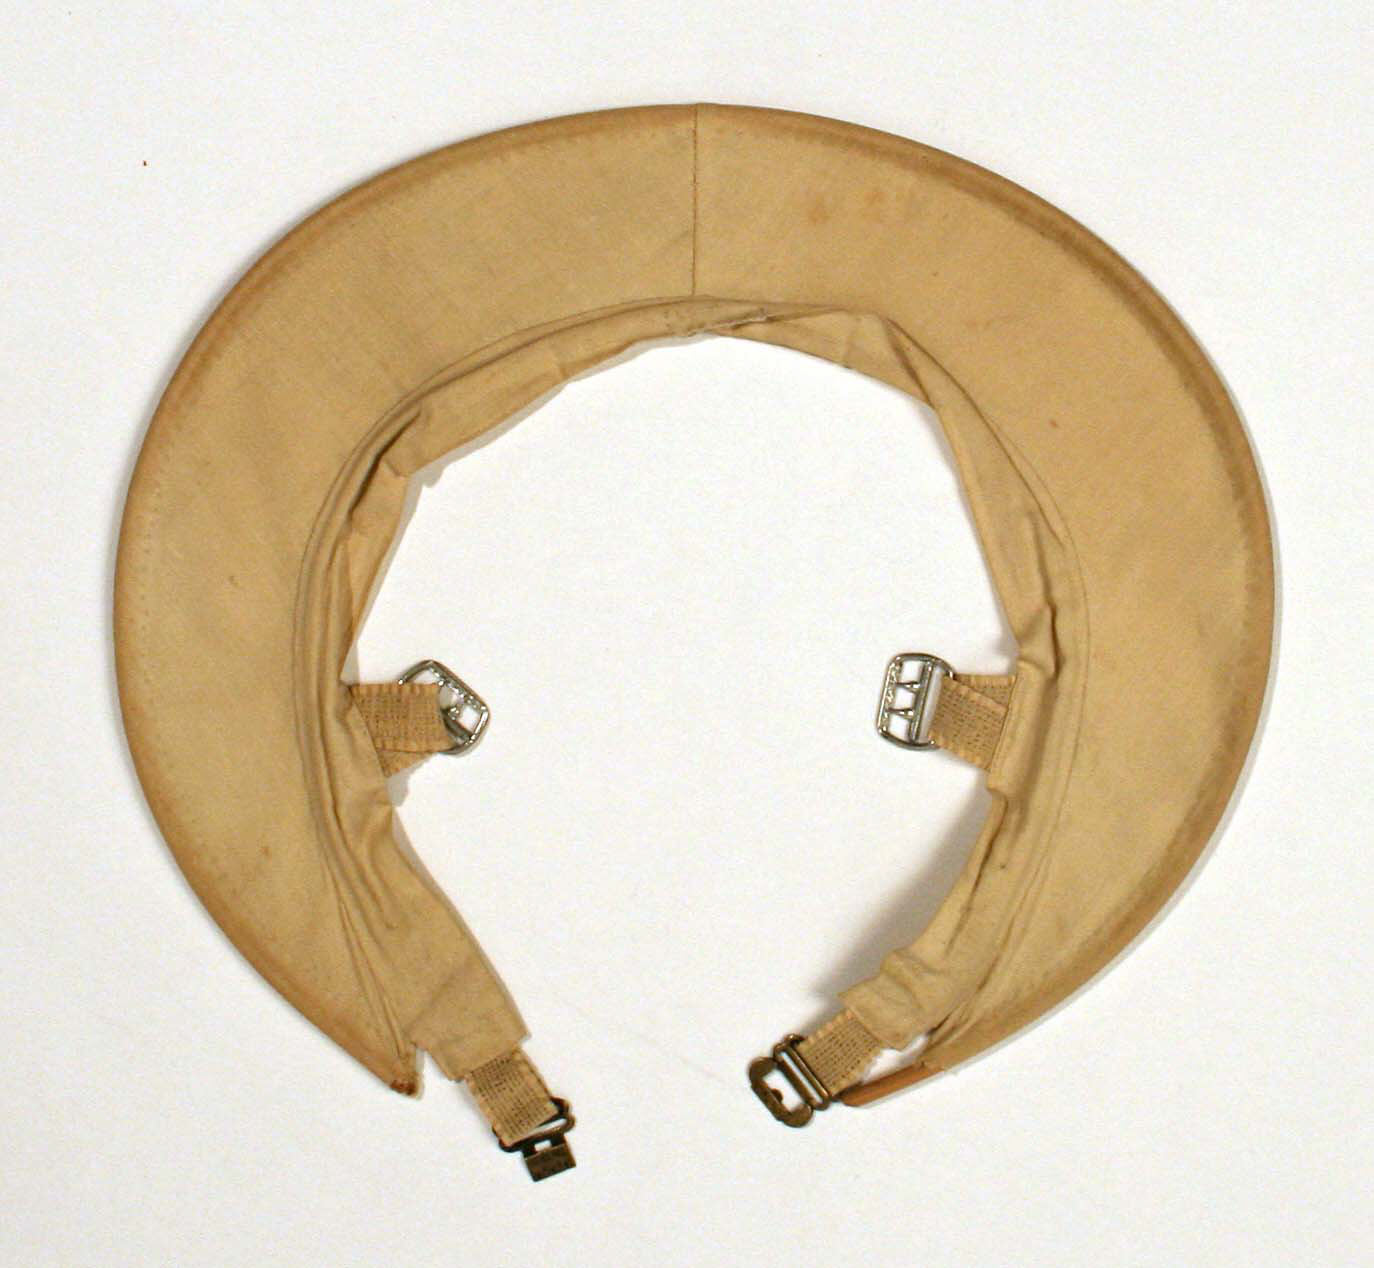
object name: bustle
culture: american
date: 1850-1875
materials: cotton